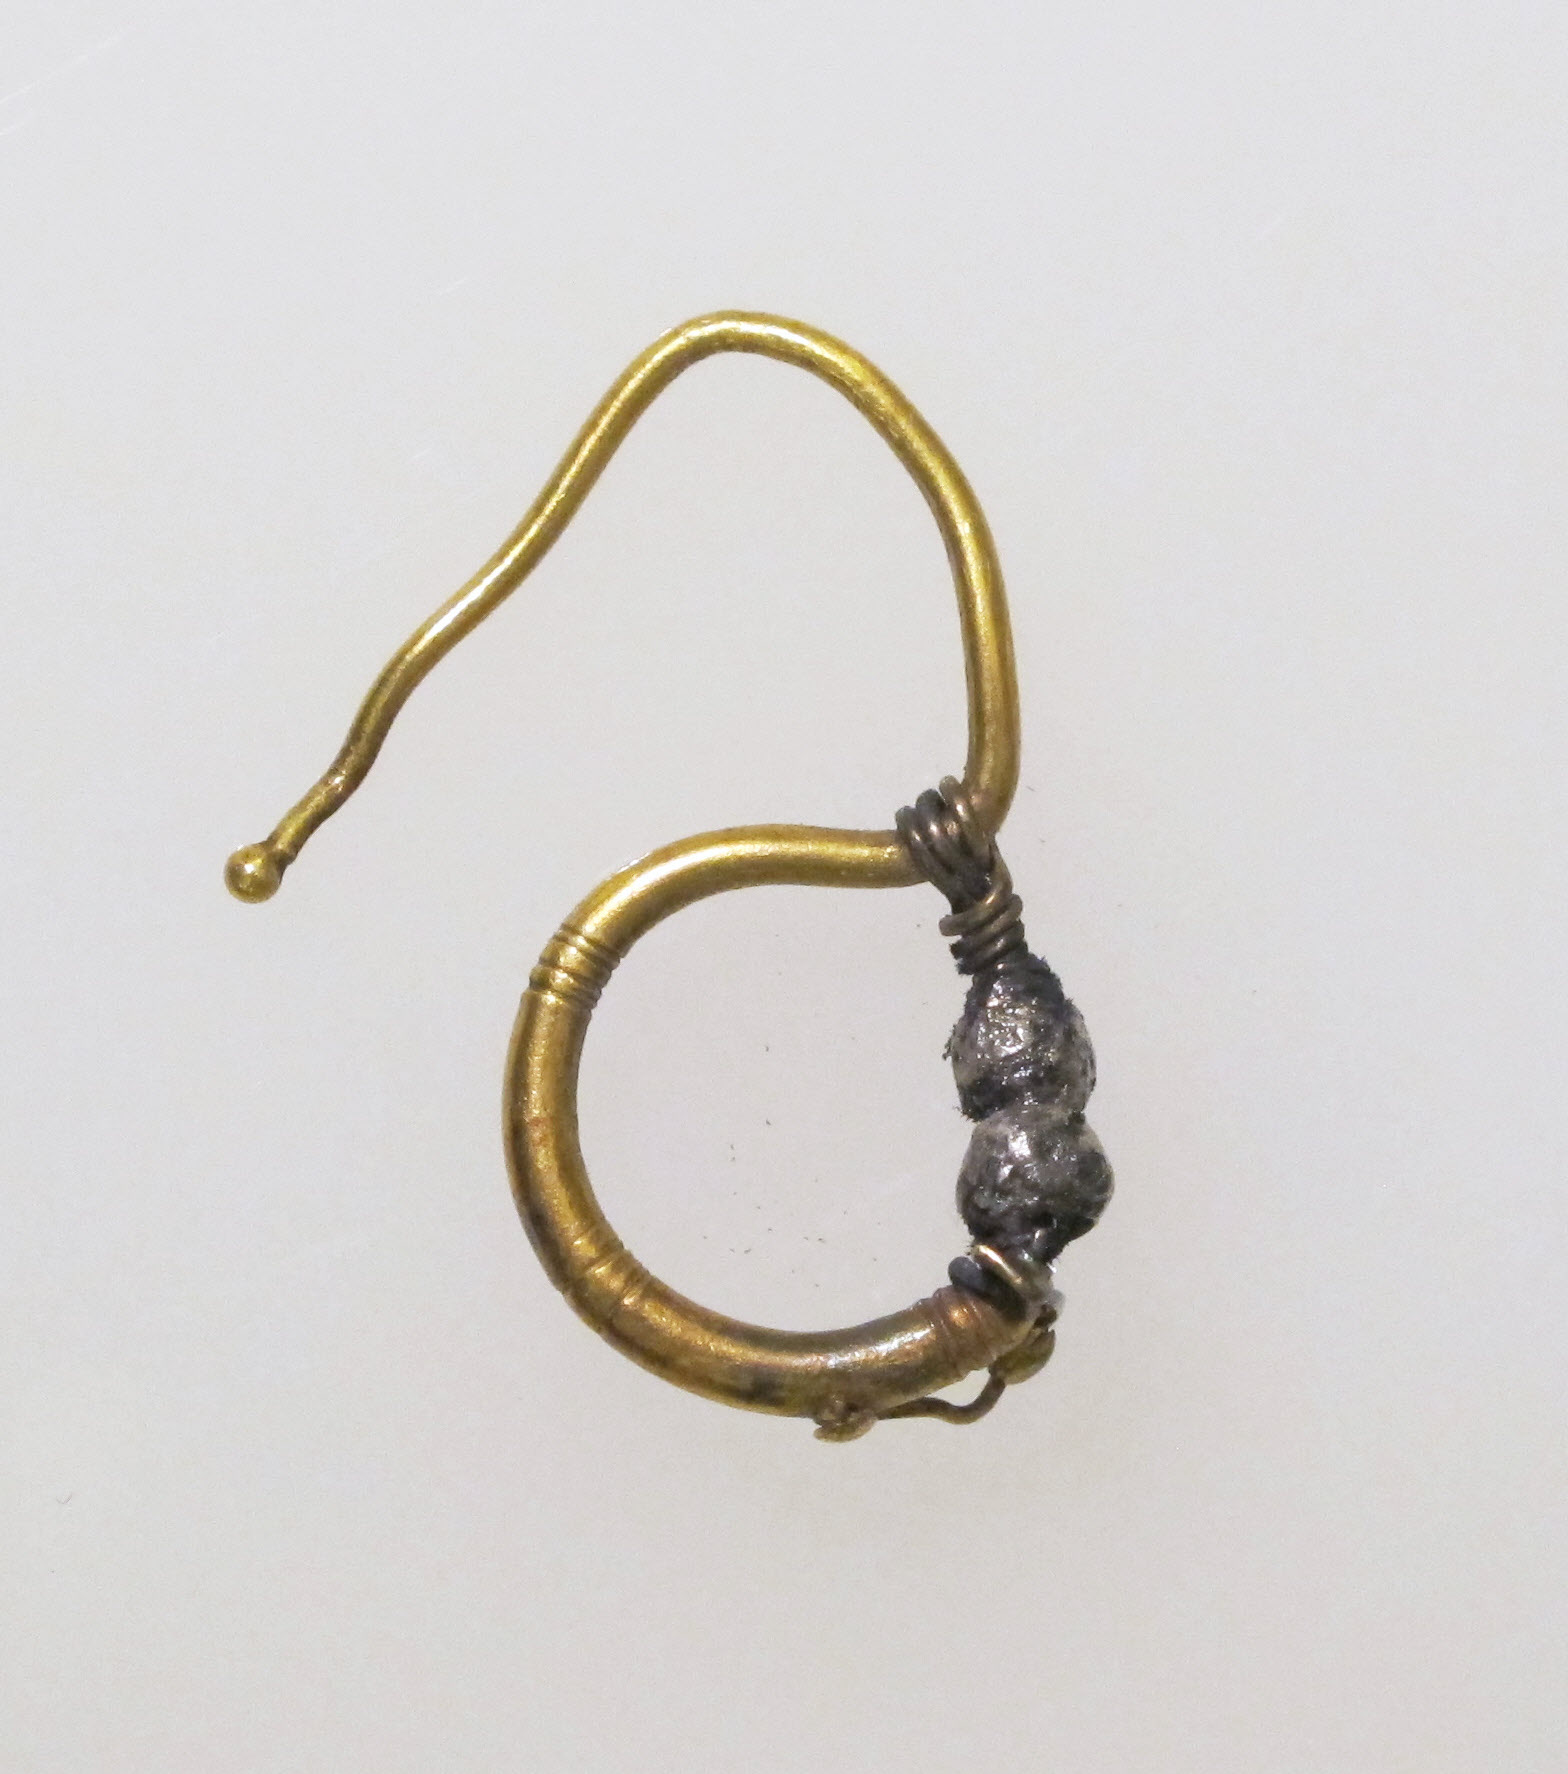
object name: earring, delta shaped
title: Earring, delta-shaped with beads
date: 7000 BCE-330 CE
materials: gold, silver